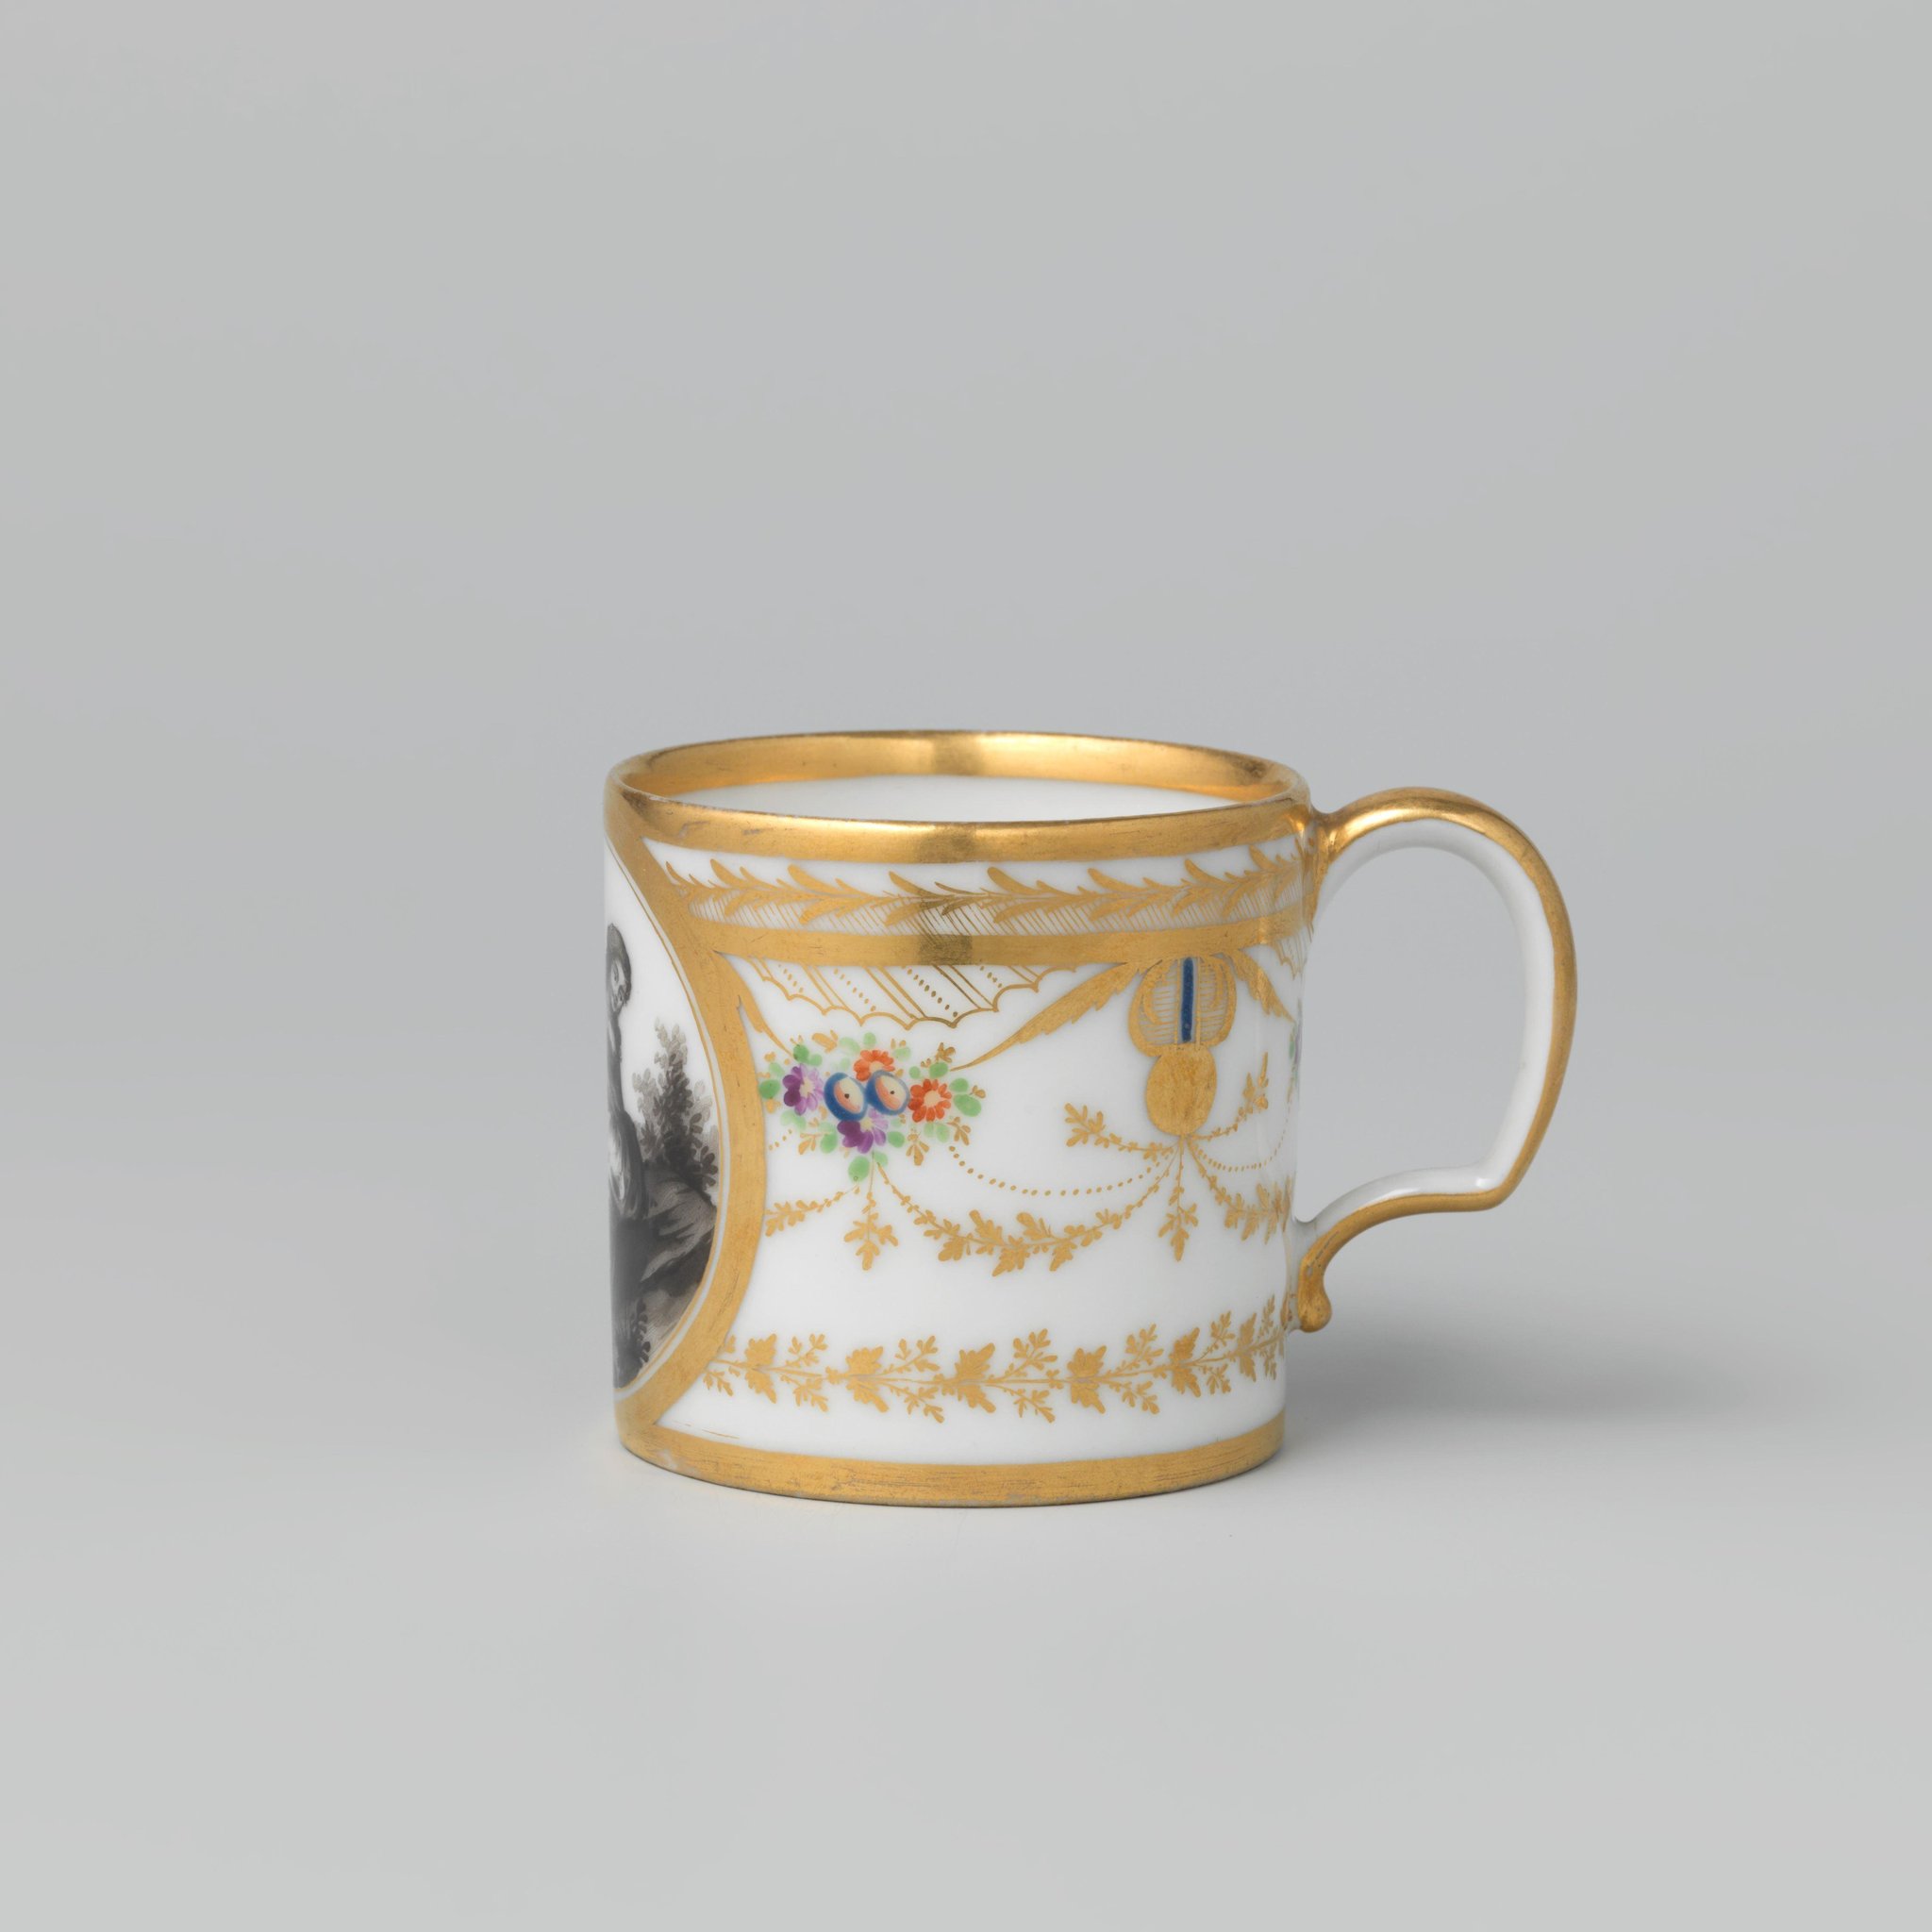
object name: cup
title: Cup with a lady holding a bird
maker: Anonymous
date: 1790-1800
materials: glaze, gold, paint, porcelain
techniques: forming, gilding, turning, vitrification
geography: france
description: Kop van porselein met een cilindrische wand en aan de onderzijde naar binnen gebogen oor, beschilderd op het glazuur in blauw, rood, groen, geel, paars, zwart en goud. Op de buitenwand een gouden medaillon met daarin in grisalle een dame in een landschap, zittend op een rots. In haar ene hand heeft zij een stok, met de andere hand staat ze op het punt een vogel vrij te laten. Om het medaillon decoratieve banden met guirlandes, blad- en bloemranken. Gouden oor.